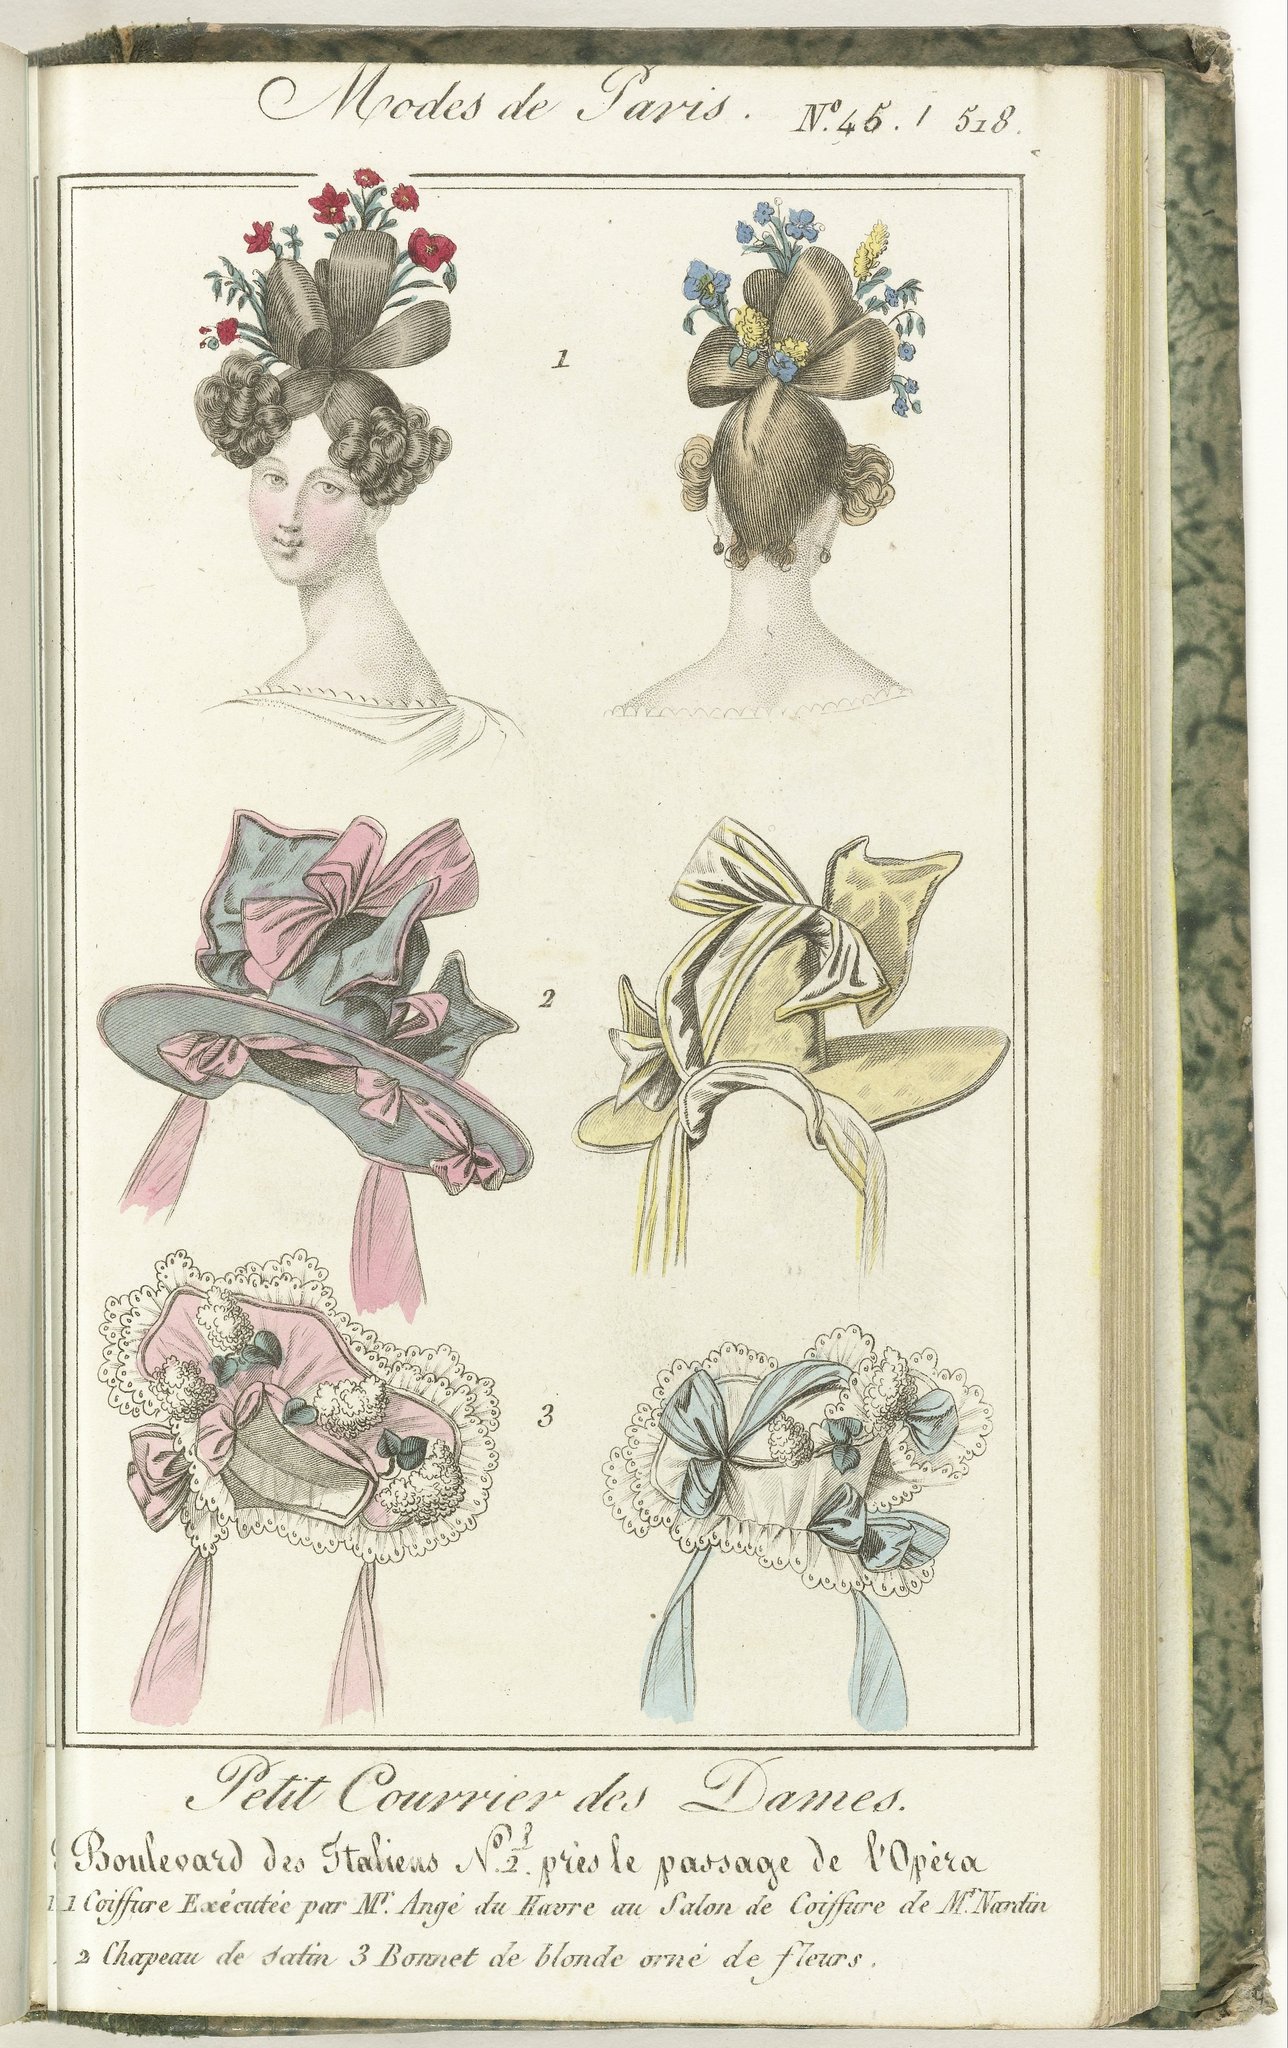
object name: fashion print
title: Petit Courrier des Dames, 10 décembre 1827, No. 45 /518: 1. Coiffure Exécutée par M.r Angé...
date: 1827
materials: paper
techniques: engraving, hand coloring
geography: paris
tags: flowers, lace (+ women's clothes), styles of hairdress - aa - ~ women, head-gear: cap (+ women's clothes), head-gear (bonnet) (+ women's clothes), fashion plates, head-gear: hat (+ women's clothes)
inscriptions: title: ‘Petit Courrier des Dames.’, title: ‘Modes de Paris.’, address: ‘Boulevard des Italiens No.2 près le passage de l'Opèra.’, caption: ‘1 Coiffure Exécutée par M.r Angé du Havre au Salon de Coiffure de M.r Nardin 2 Chapeau de satin 3 Bonnet de blonde orné de fleurs.’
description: Een kapsel, een hoed en een muts, van de voor- en achterzijde weergegeven, genummerd één tot en met drie. 1 Coiffure Exécutée par Mr Angé du Havre au Salon de Coiffure de Mr Nardin 2 Chapeau de satin 3 Bonnet de blonde orné de fleurs.. Prent uit het modetijdschrift Petit Courrier des Dames (1821-1868). Ingebonden (met enkele pp. Le Journal des Dames et des Modes). 15 Januari 1827 t/m 20 maart 1830. Incompleet.